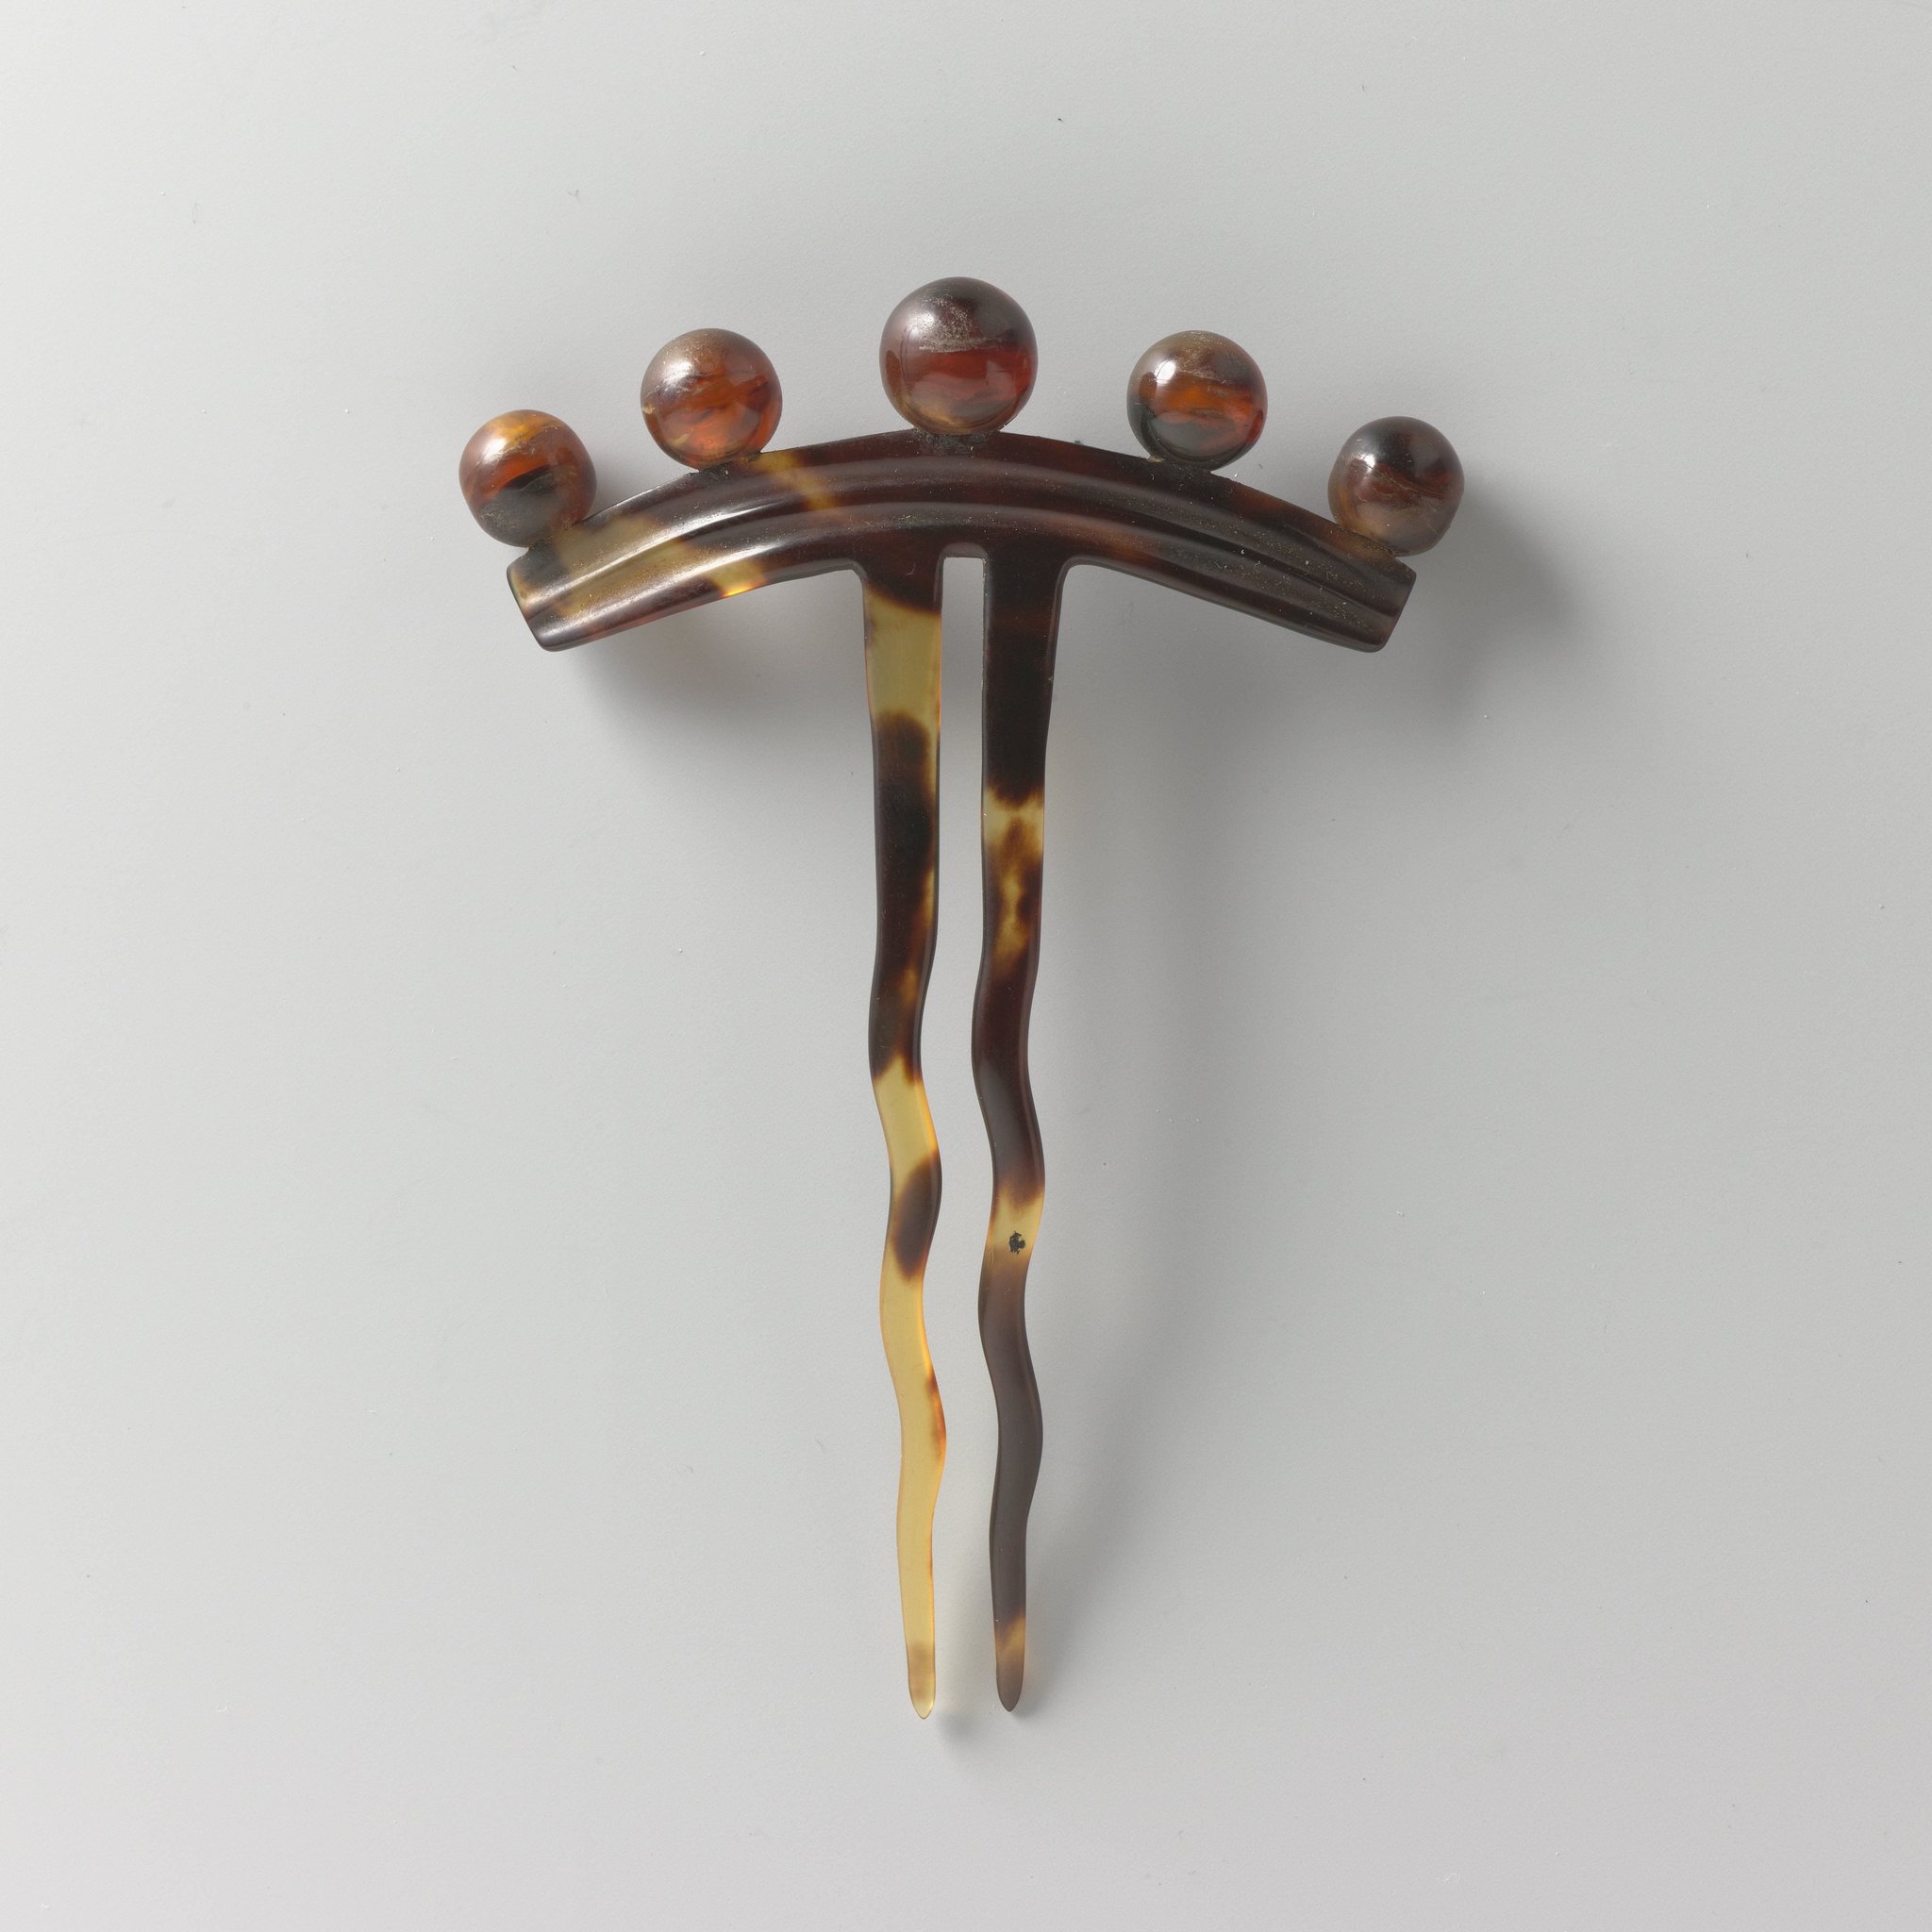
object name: comb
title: Haarkam van imitatie schildpad met smalle rug waarop vijf bollen, twee geslingerde tanden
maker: Anonymous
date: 1885-1900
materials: celluloid, plastic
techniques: assembly, filing, polish, pressing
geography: netherlands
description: Een kleine kam met bolronde beugel, bekroond met vijf bollen en onderaan twee geslingerde tanden. Van donker schildpad.